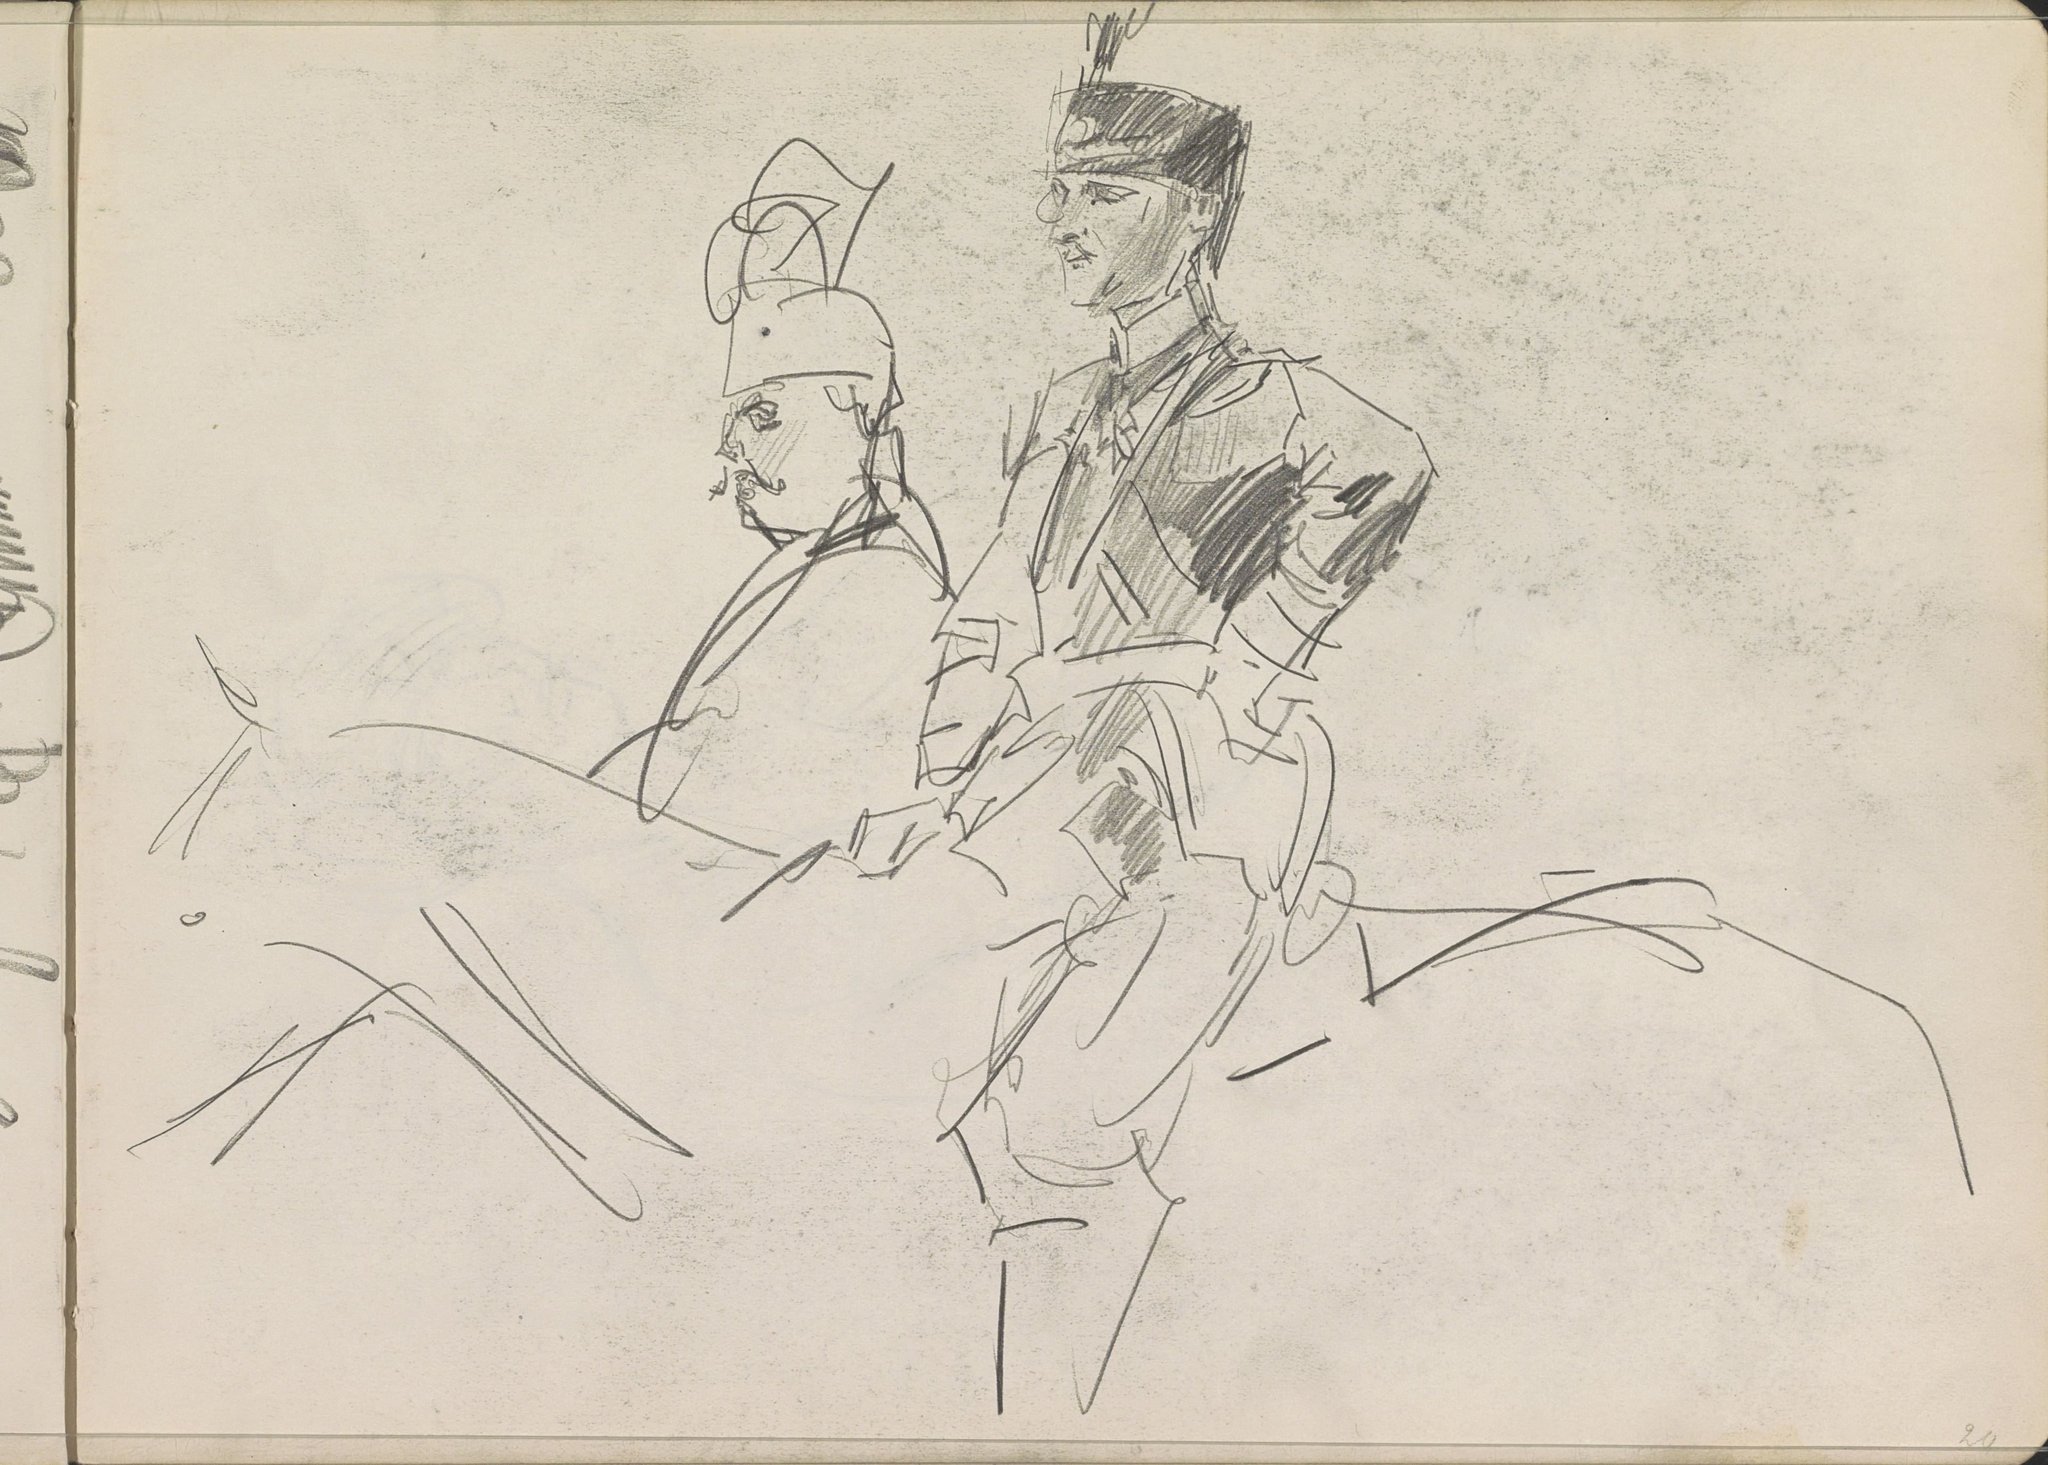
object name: sketchbook leaf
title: Twee ruiters, mogelijk huzaren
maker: isaac israels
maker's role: draughtsman, painter, print maker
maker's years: 1865-1934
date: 1915-1934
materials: paper, pencil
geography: the hague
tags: riding a horse, ass, or mule; rider, horseman, private soldier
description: Blad 20 recto uit schetsboek VI met 33 bladen.